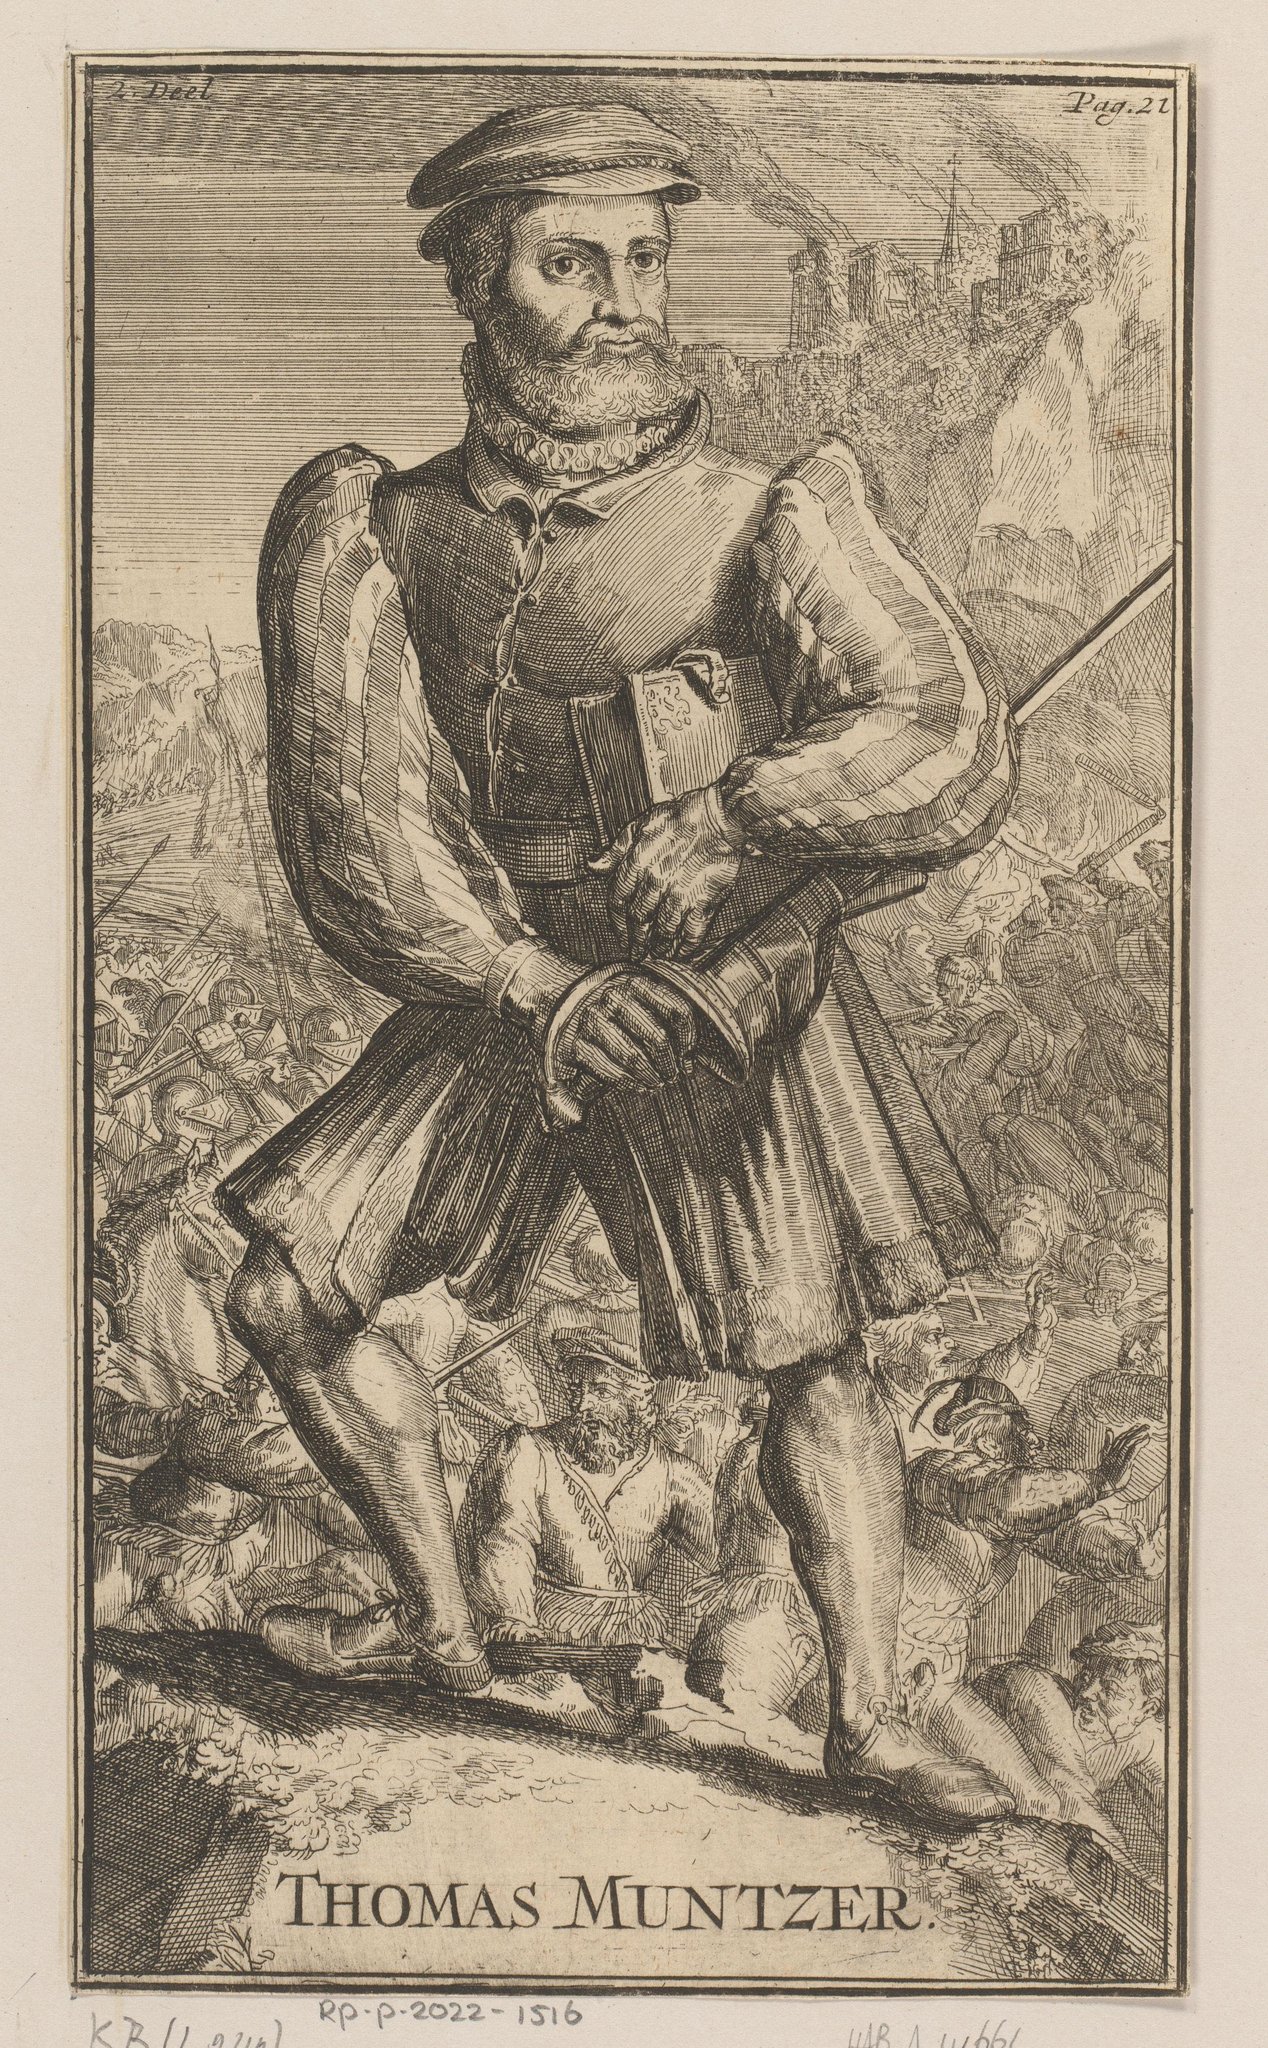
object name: book illustration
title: Historie der Kerken en ketteren (...) tot aan het jaar onses Heeren 1688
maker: romeyn de hooghe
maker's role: draughtsman, goldsmith, painter, print maker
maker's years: 1645-1708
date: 1701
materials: paper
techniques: engraving, etching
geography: northern netherlands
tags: mühlhausen, theologian, historical persons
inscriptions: collector's mark: Lugt 240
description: Prent waarschijnlijk uit: Arnold, Godfried. Historie der kerken en ketteren van den beginne des Nieuwen Testaments tot aan het jaar onses Heeren 1688. Amsterdam: Sebastiaan Petzold, 1701, dl. 2, p. 21.